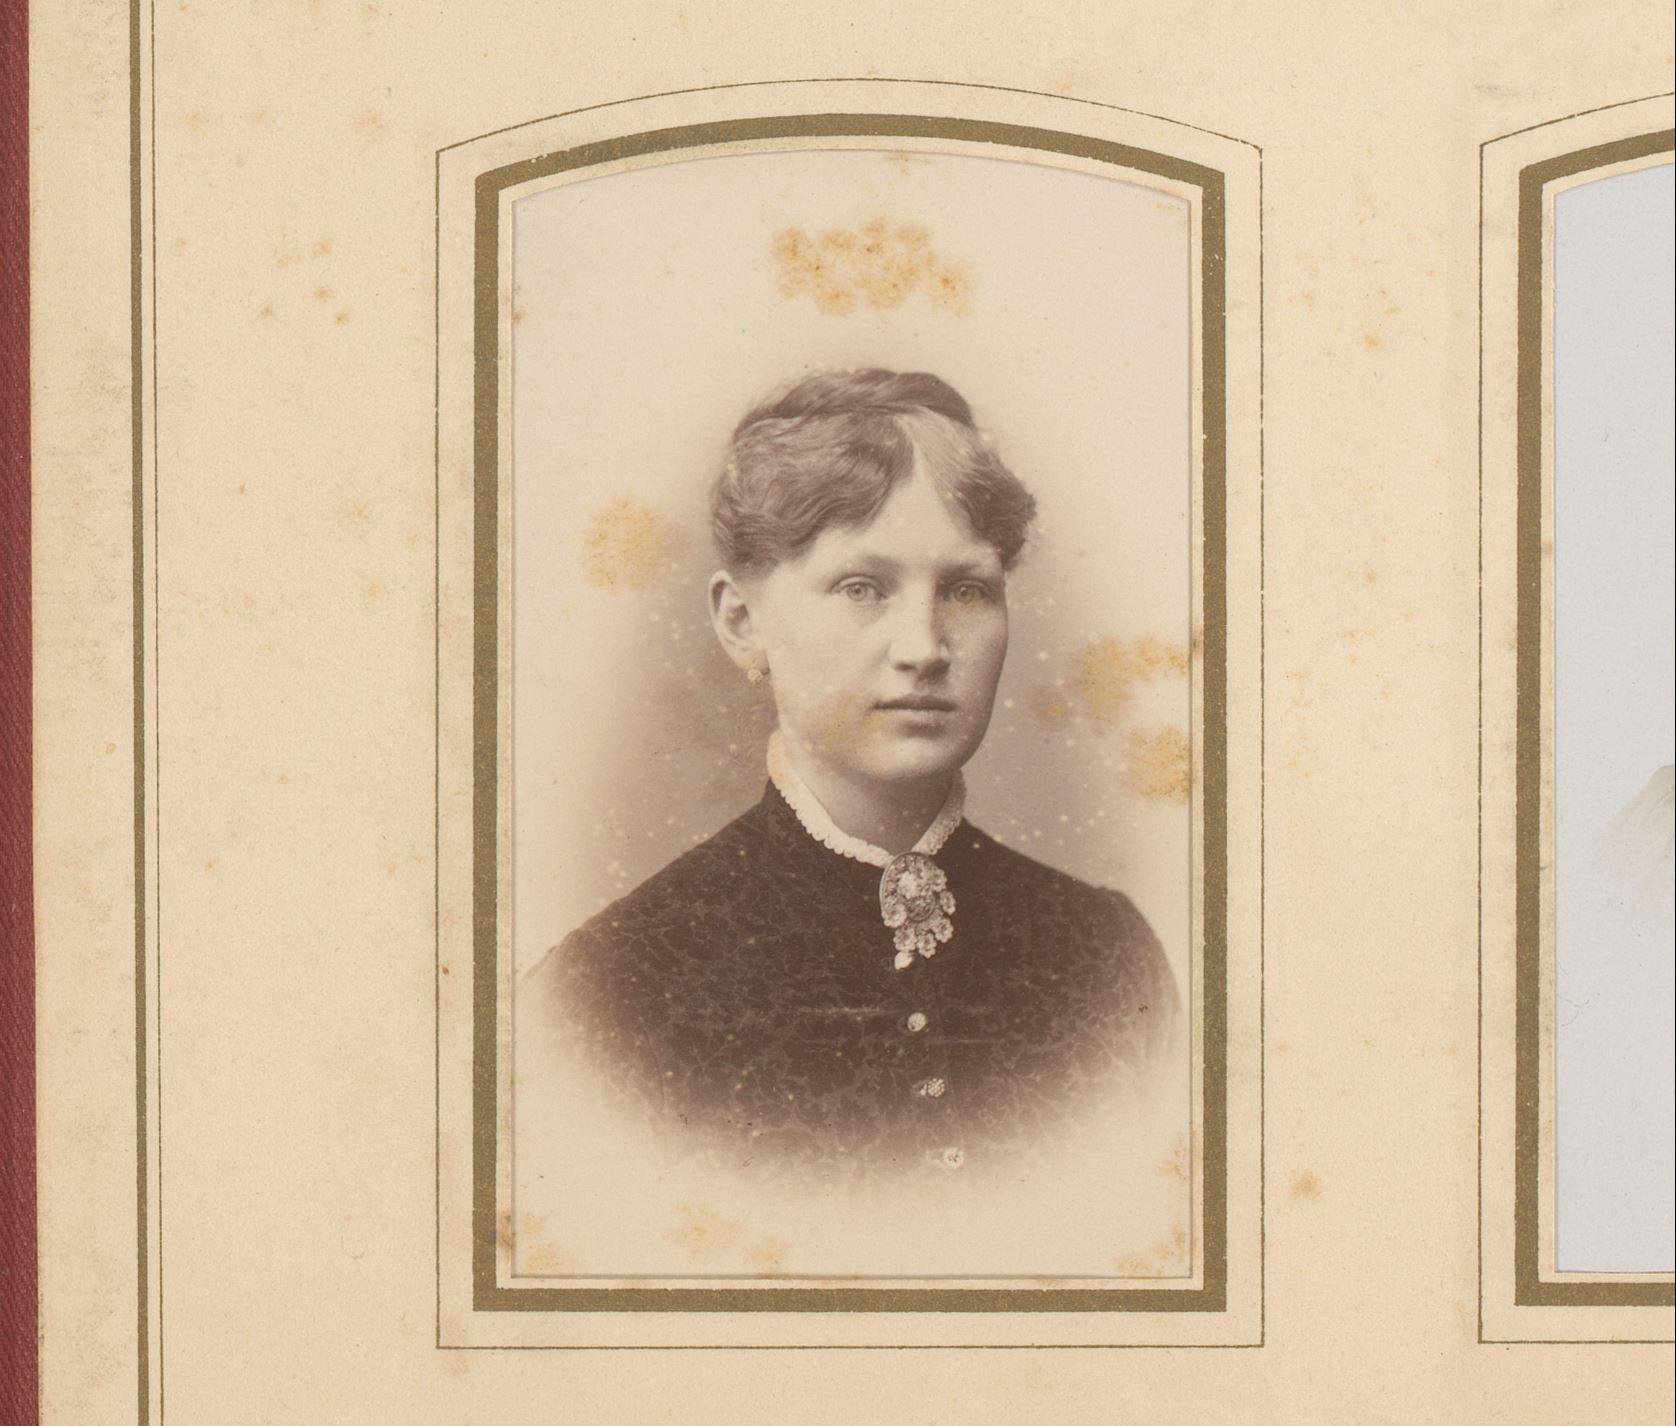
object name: photograph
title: Portret van een jonge vrouw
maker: friedrich julius von kolkow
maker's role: fotograaf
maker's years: 1839-1914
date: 1876-1900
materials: cardboard, photographic support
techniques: albumen print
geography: groningen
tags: adolescent, young woman, maiden, historical persons - bb - woman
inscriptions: inscription: ‘(...)/ Fr. Jul von Kolkow/ Koninklyk Nederlandsch Hof-Photograph/ (...)/ GRONINGEN/ Groote Markt by de/ Martinitoorn./ Specialiteit in Vergrootingen’